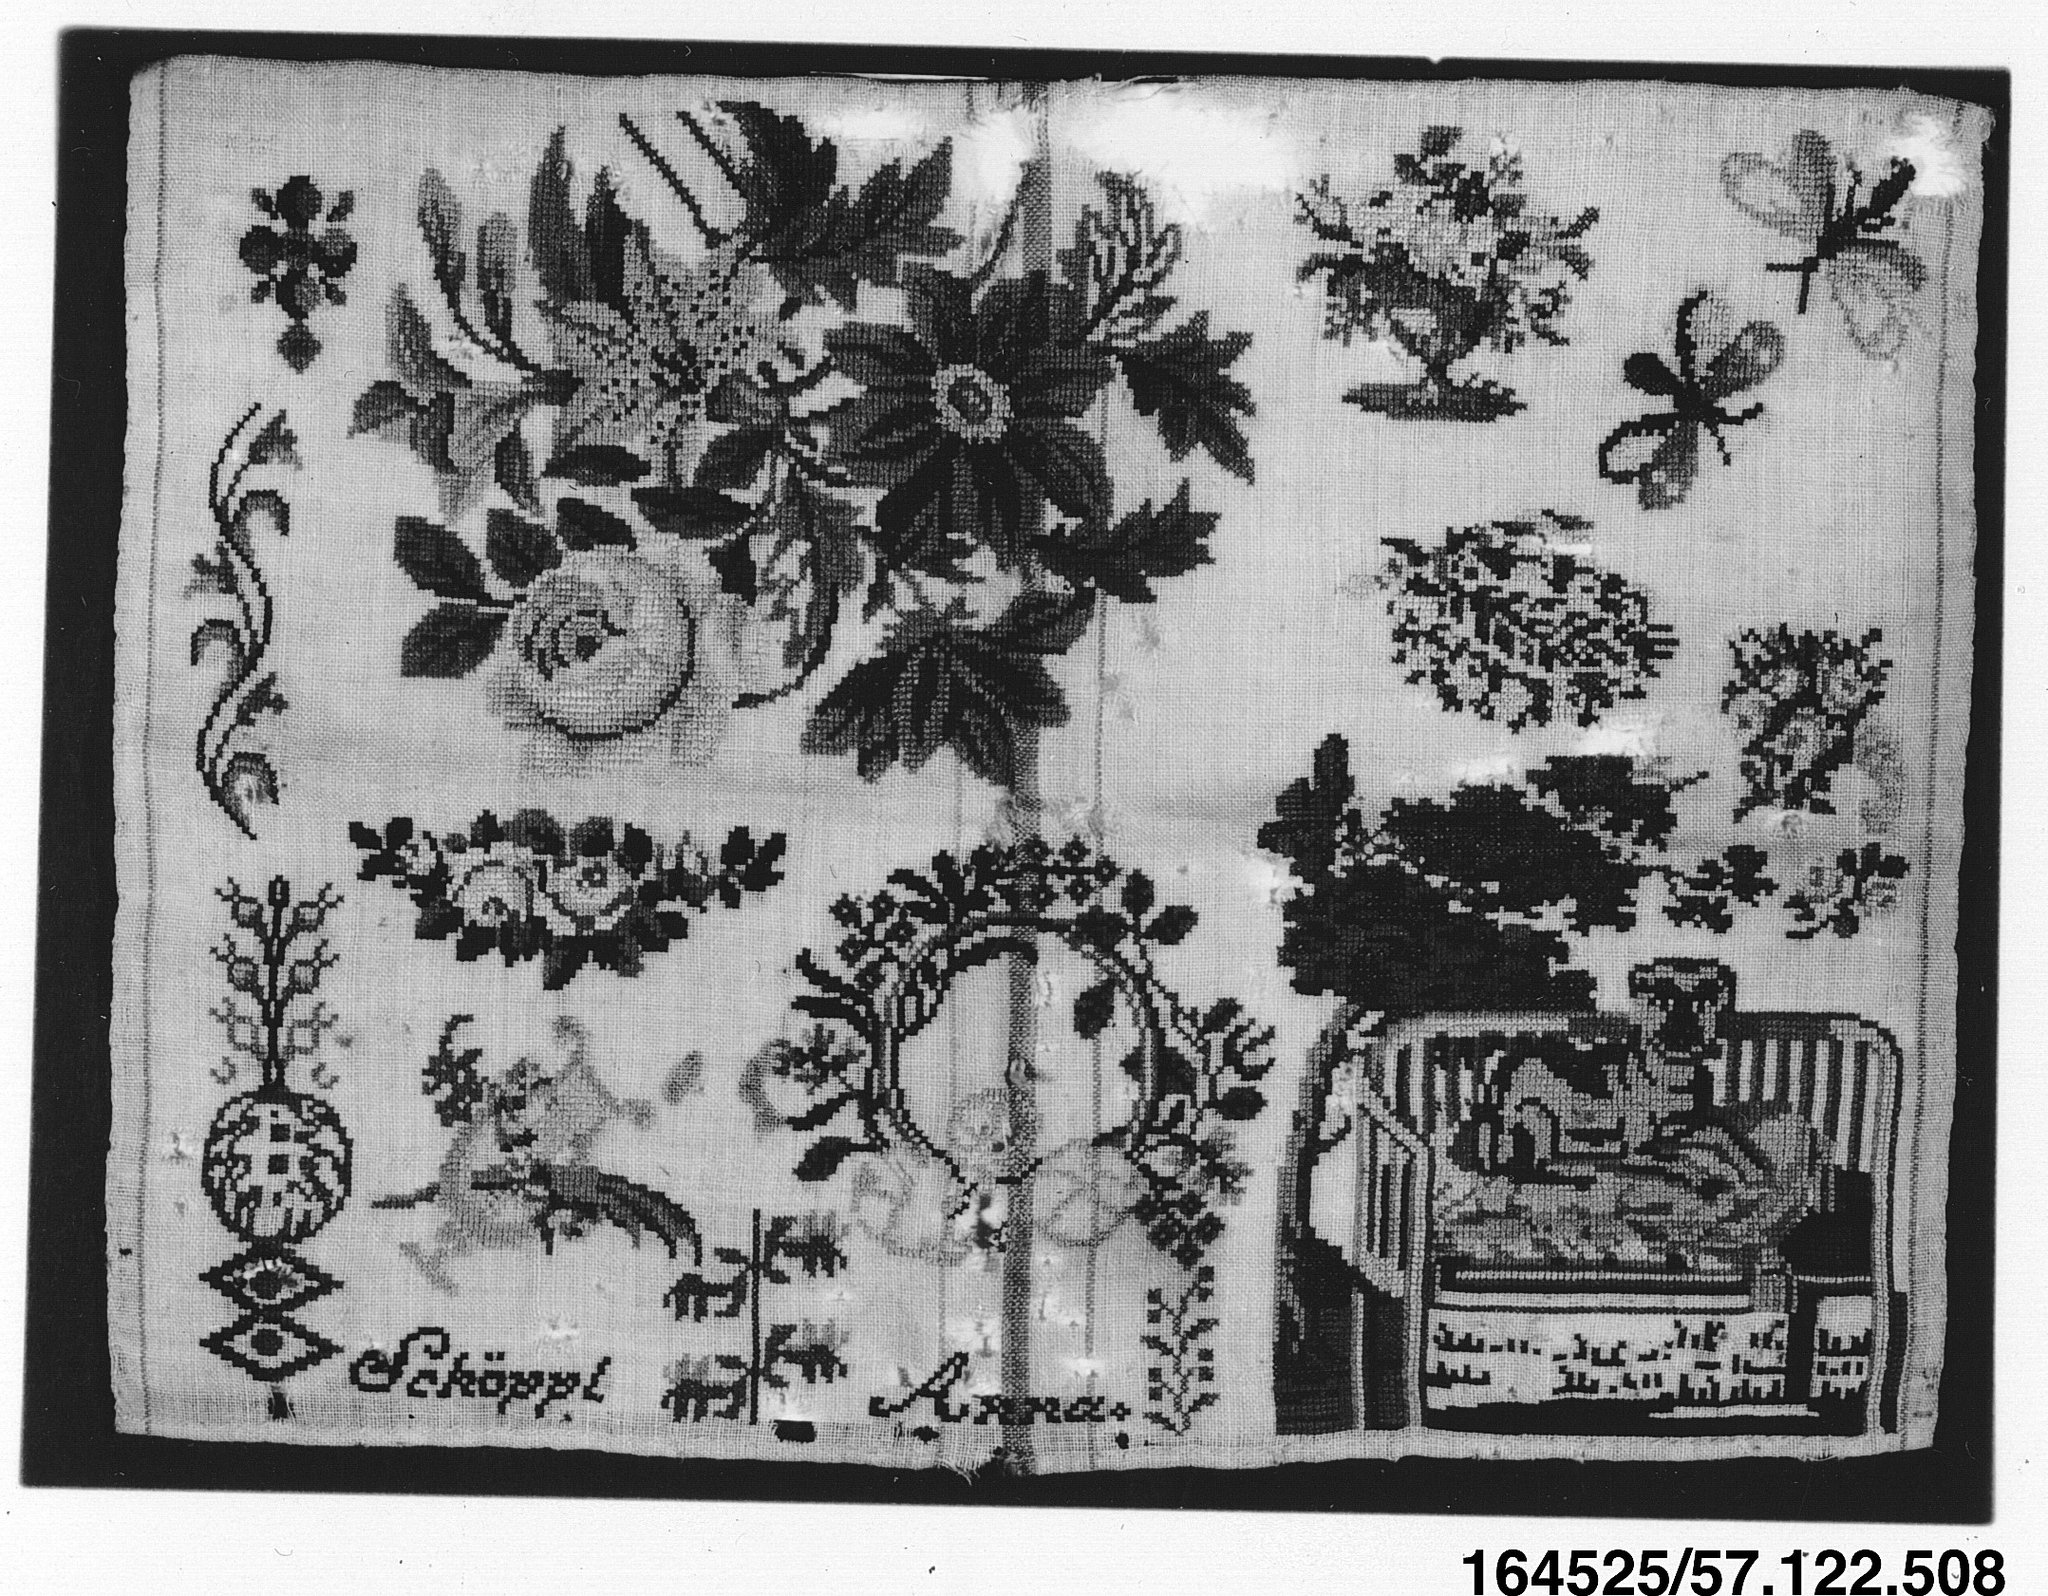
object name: sampler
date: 1801-1900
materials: canvas, silk, wool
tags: dogs,insects,flowers